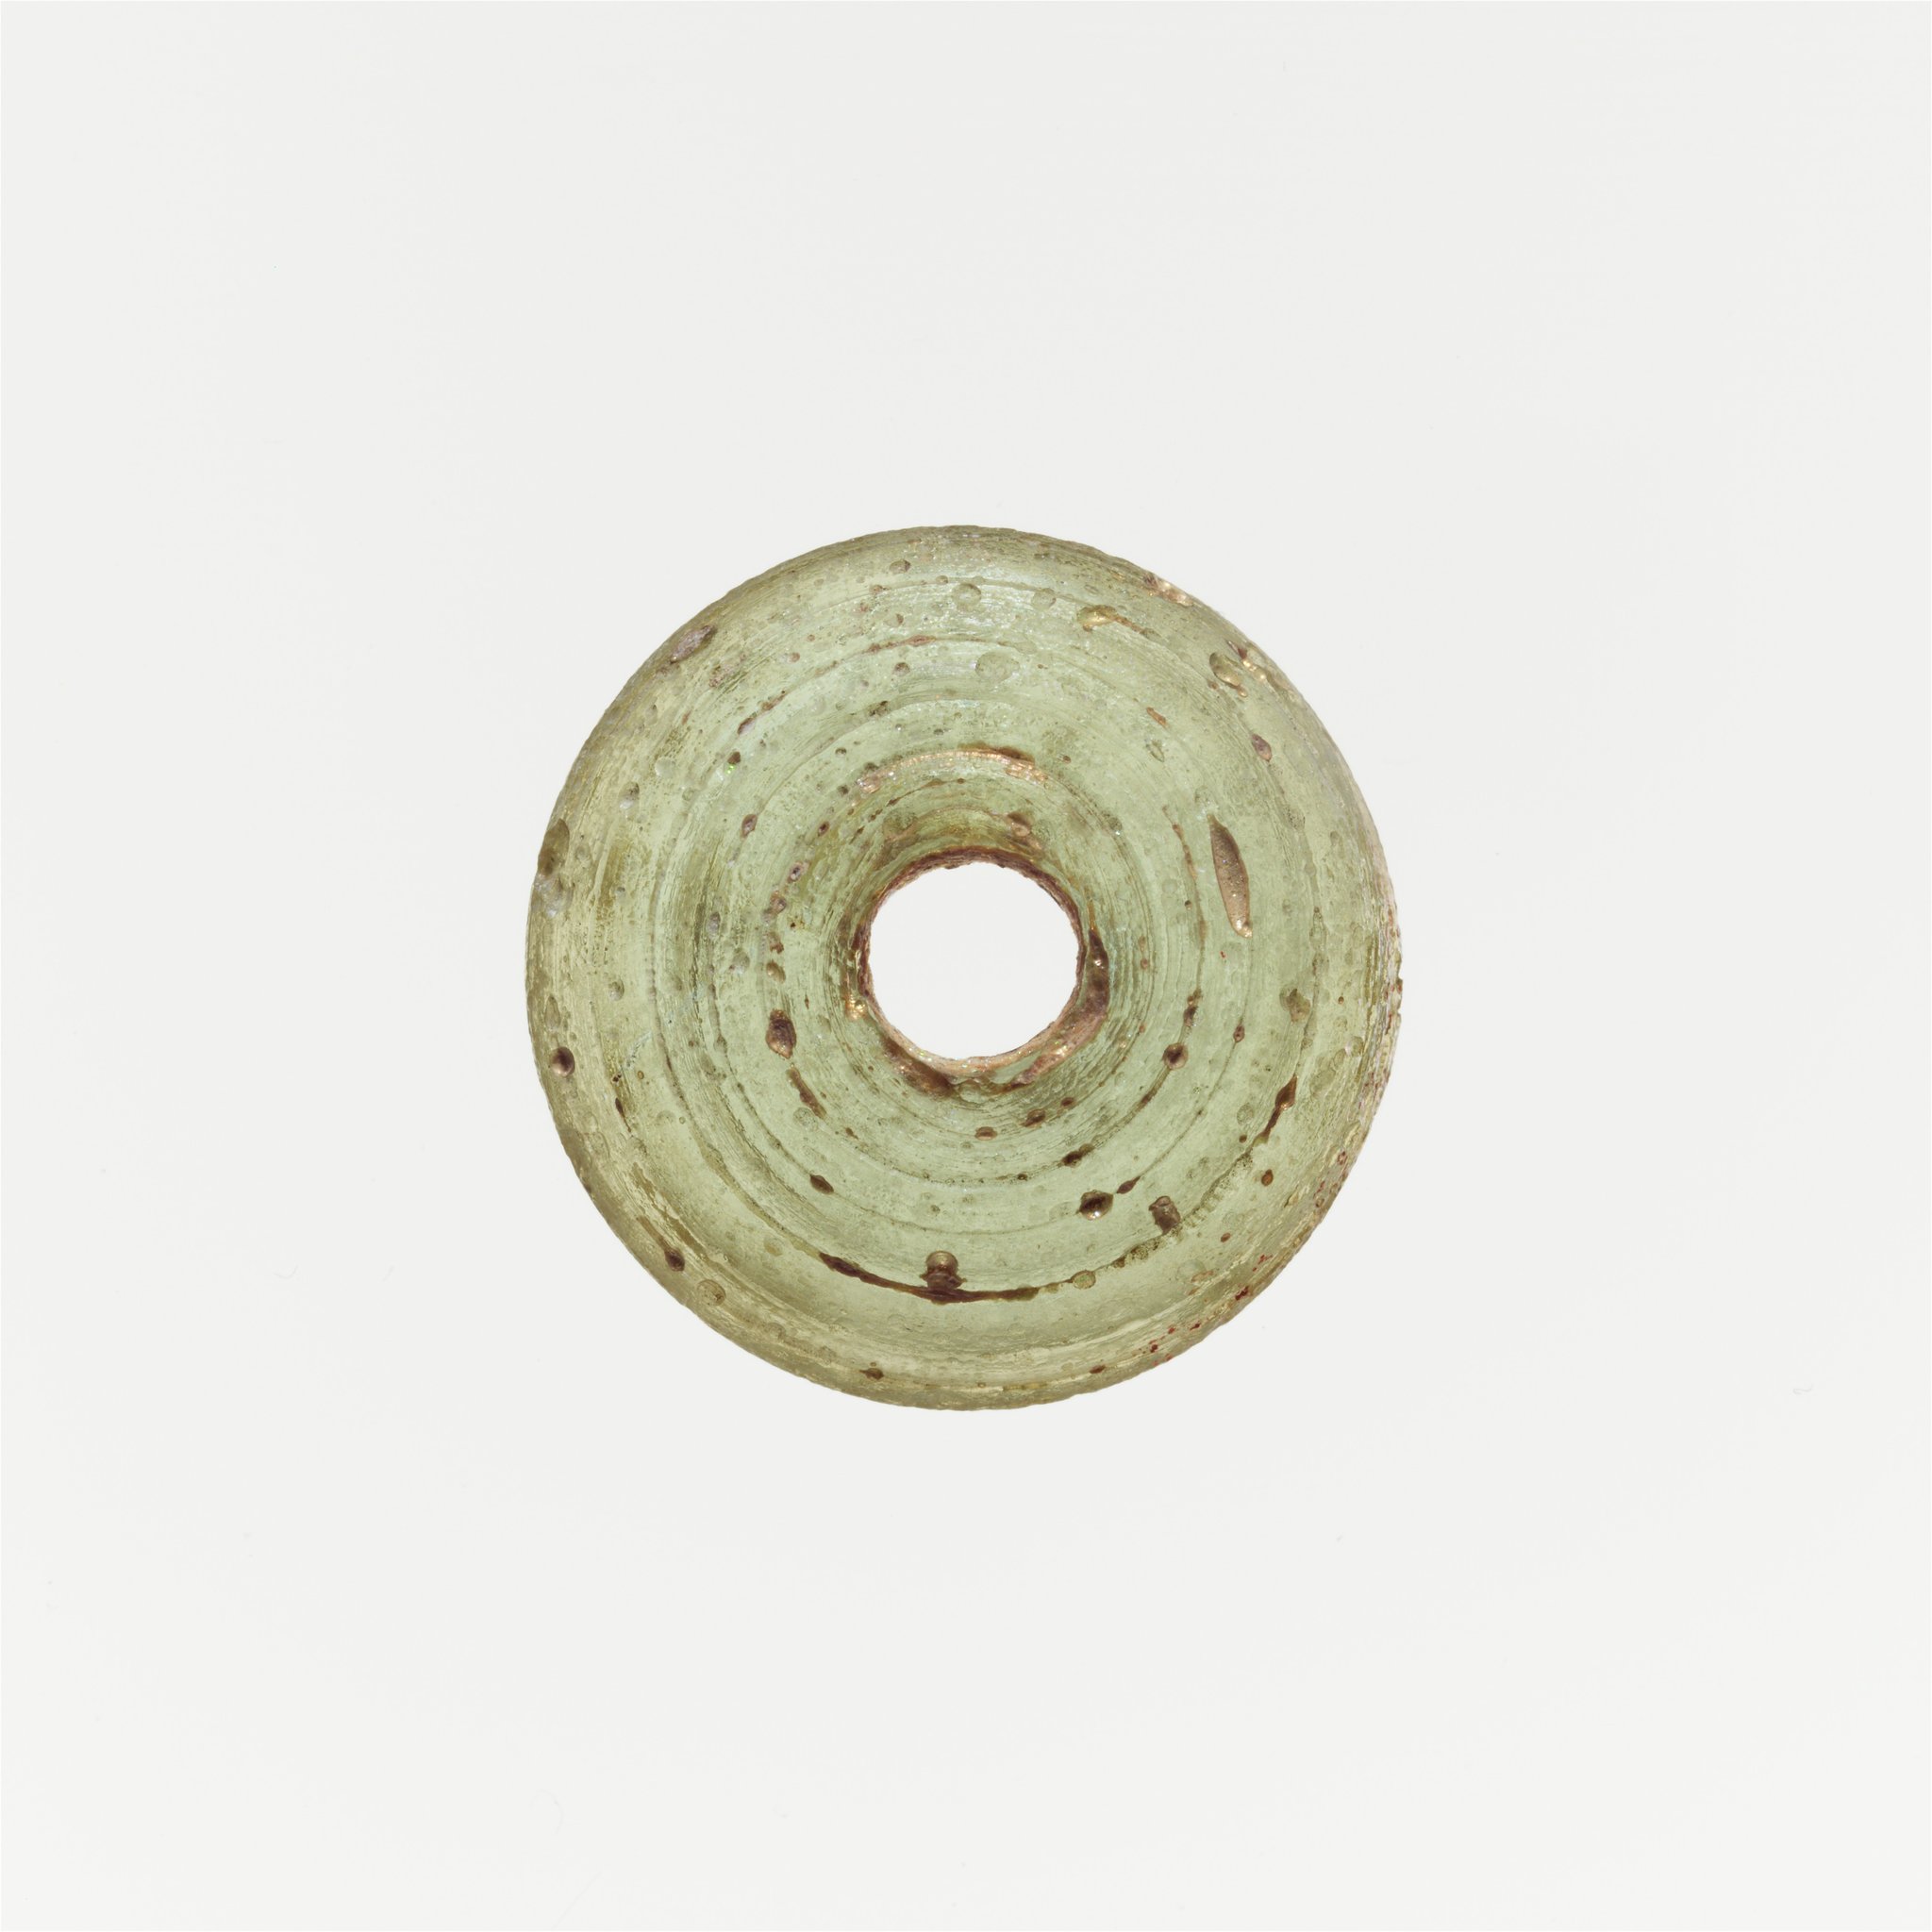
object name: spindle whorl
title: Glass spindle whorl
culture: roman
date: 1-200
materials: glass